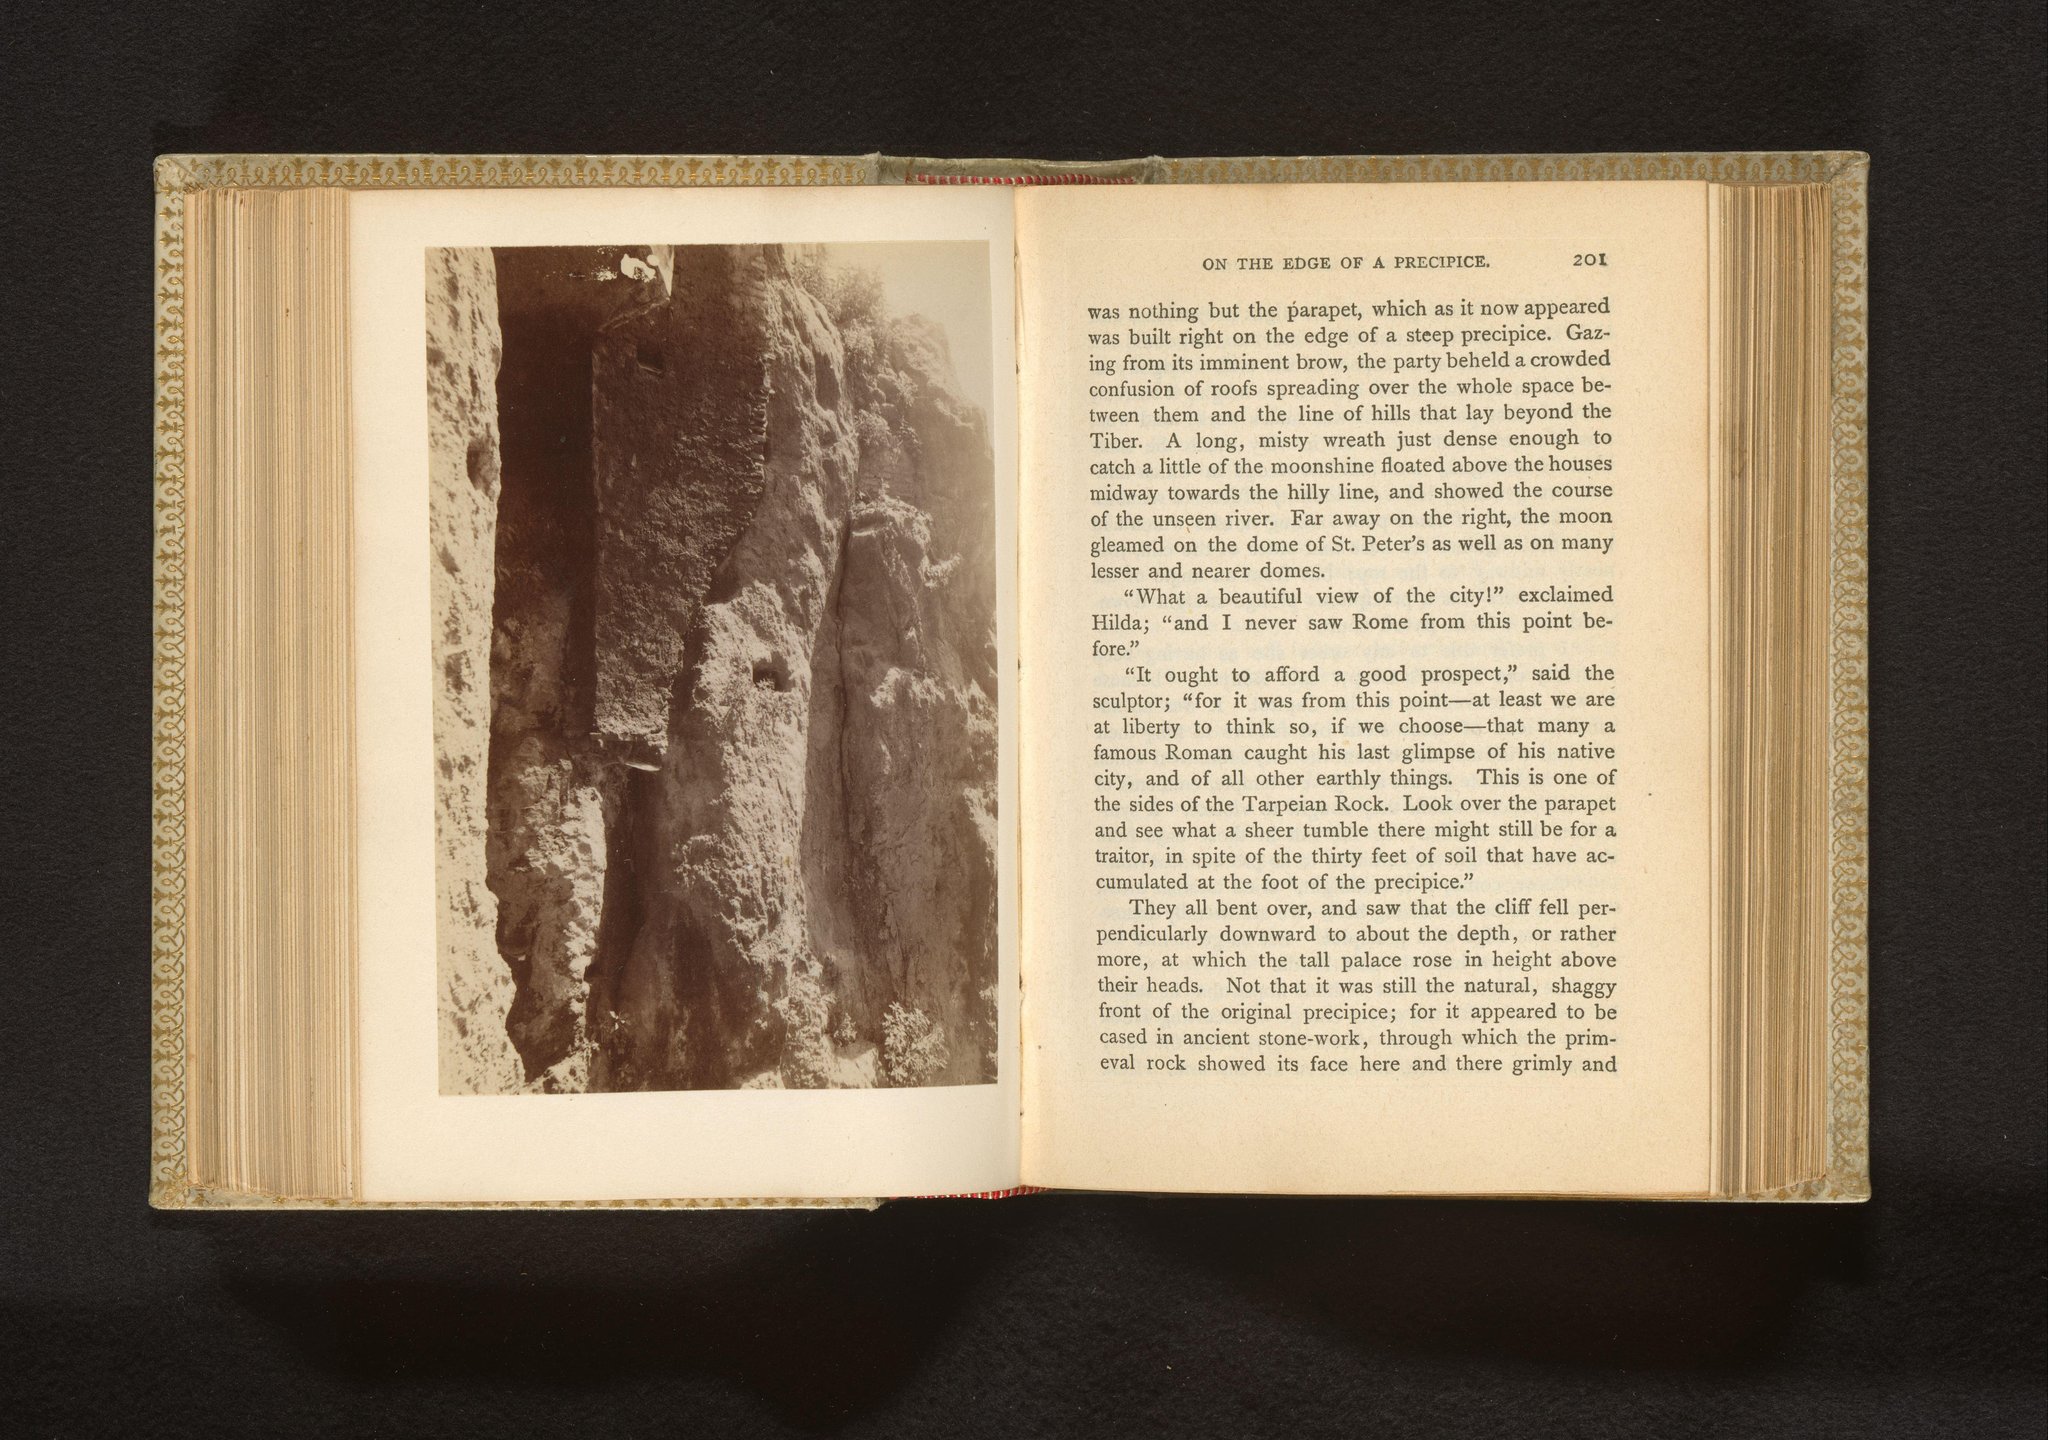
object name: photograph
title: Gezicht op de Tarpeïsche rots in Rome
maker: Anonymous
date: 1850-1860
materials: photographic support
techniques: albumen print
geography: rome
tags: rock-formations